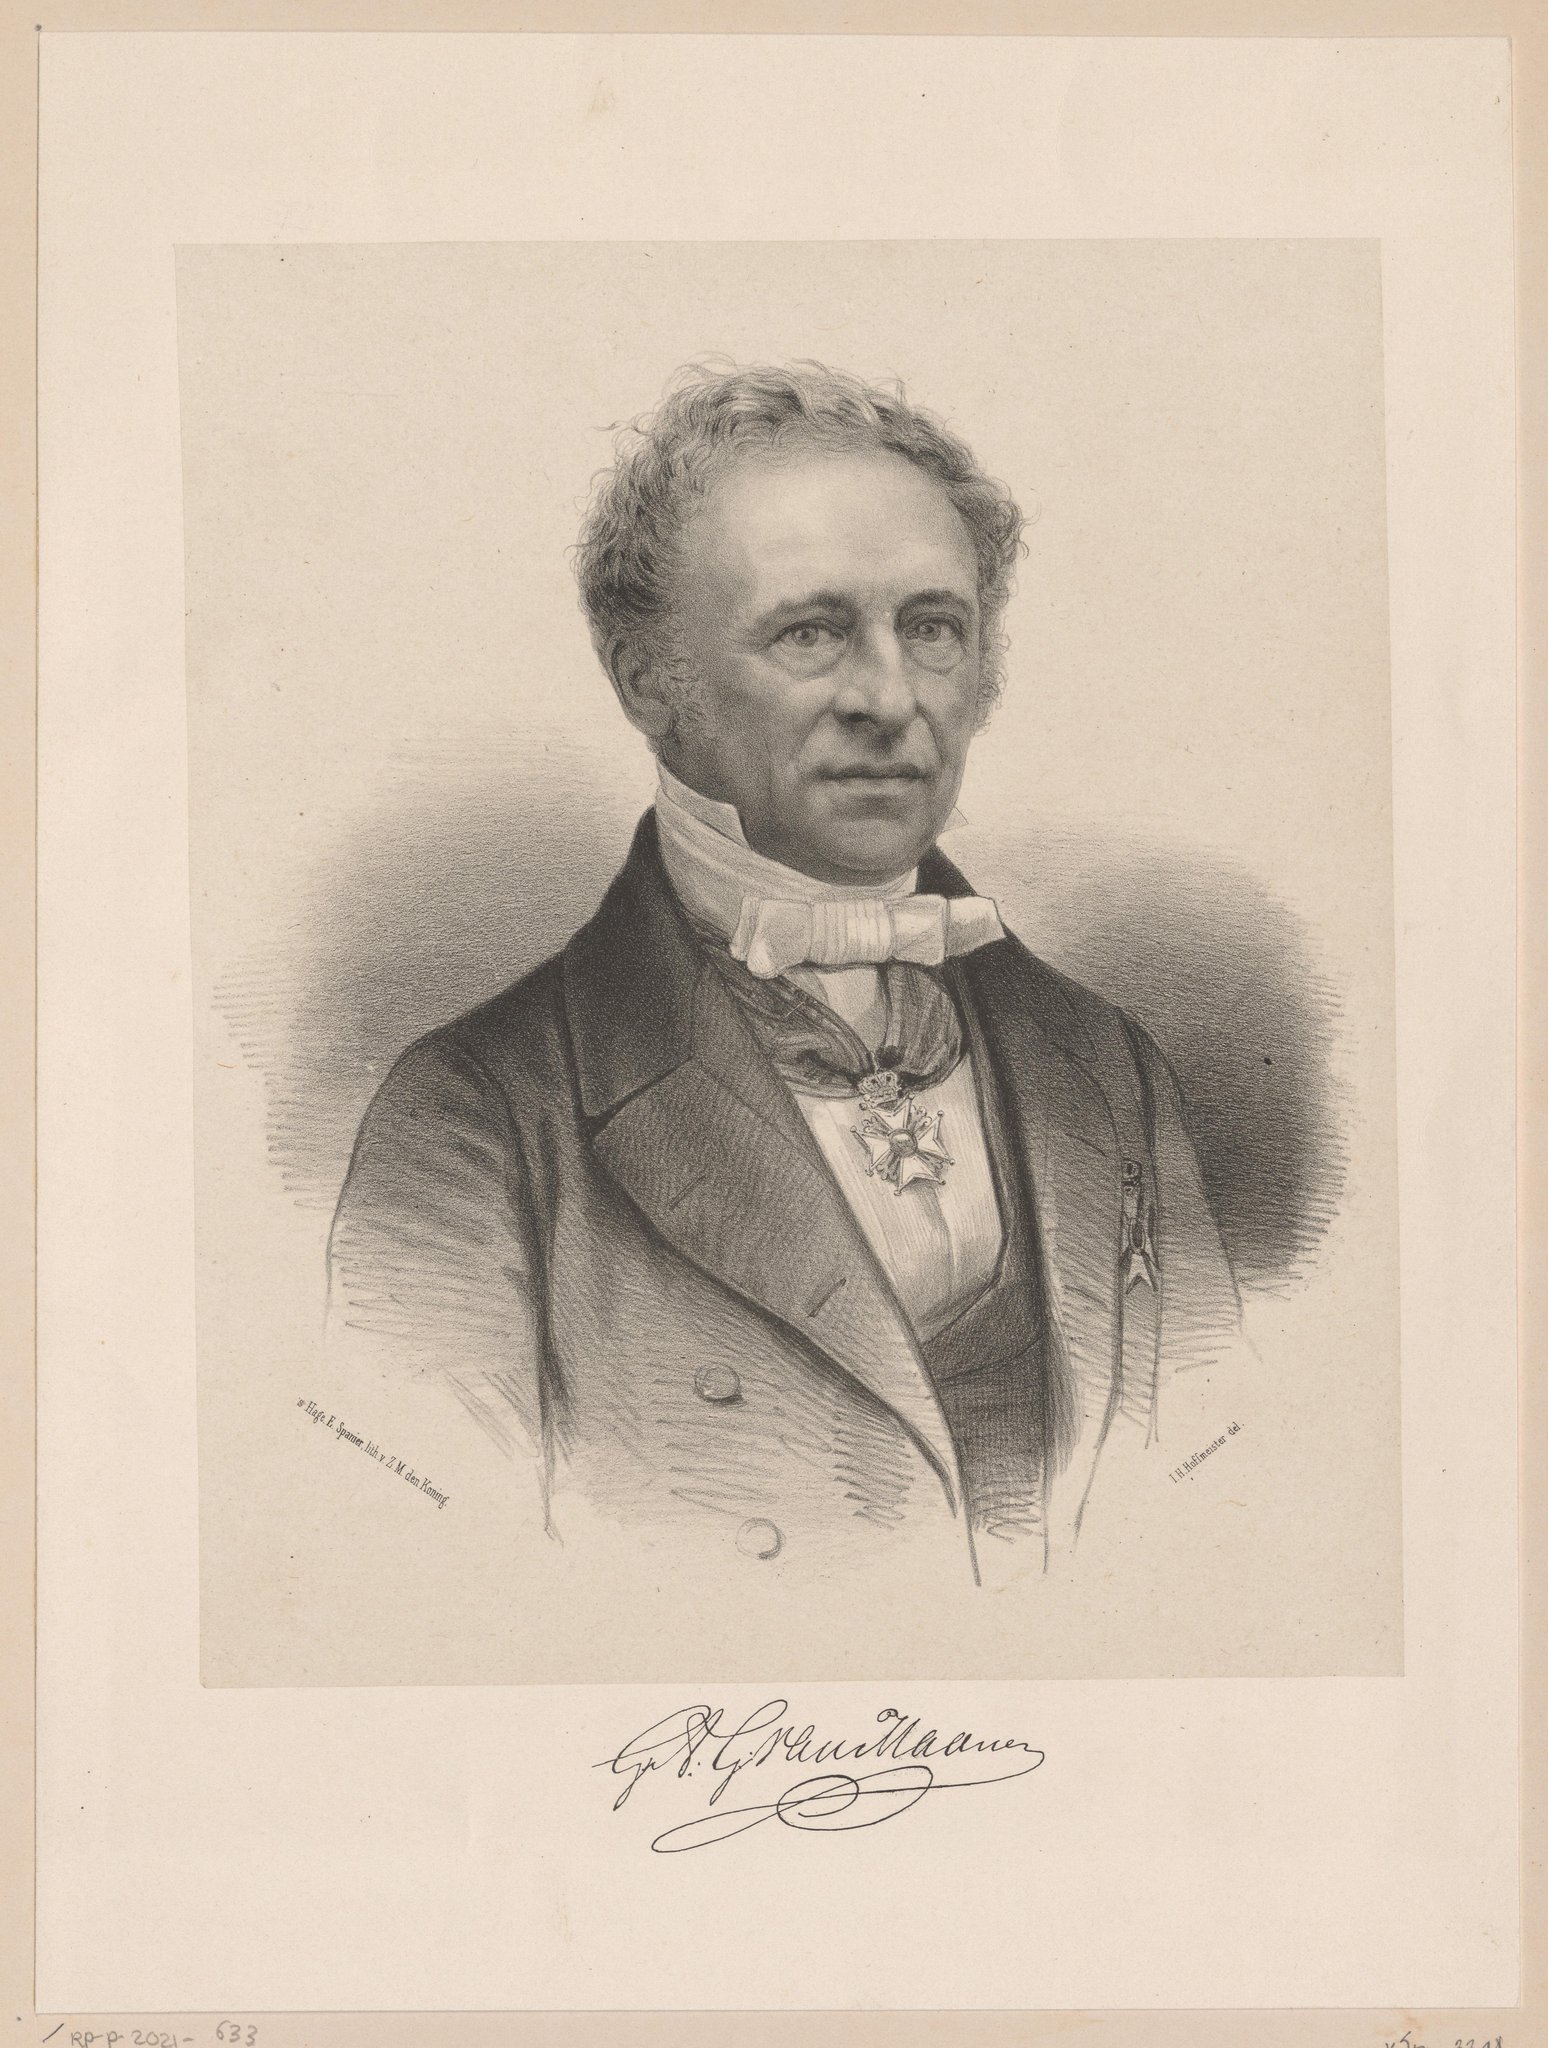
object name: print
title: Portret van Guillaume Adrien Gérard van Maanen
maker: johan hendrik hoffmeister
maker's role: print maker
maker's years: 1823-1904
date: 1851-1883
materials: paper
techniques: lithograph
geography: the hague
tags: the hague, historical persons, portrait, self-portrait of painter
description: Een facsimile signatuur in de ondermarge.